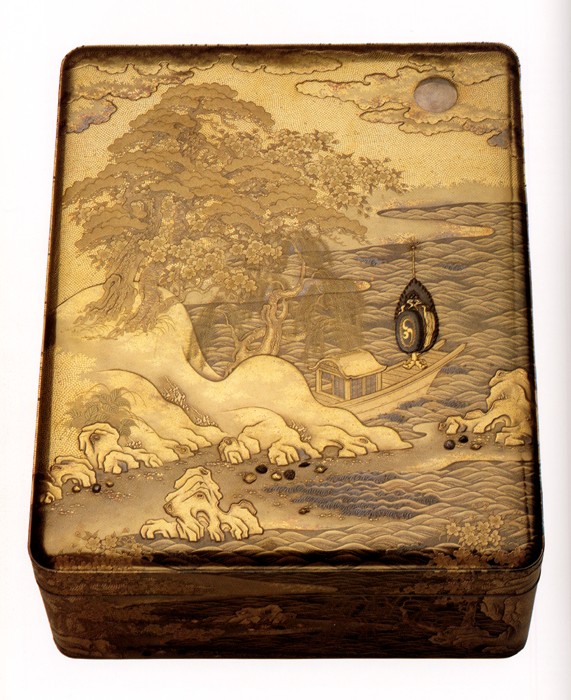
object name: document box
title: Document Box with a Scene from the “Butterflies” Chapter of The Tale of Genji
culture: japanese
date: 1901-2000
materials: gold, gold foil, gold leaf, silver, wood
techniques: cutting, hiramakie, lacquer, maki-e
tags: landscapes,boats